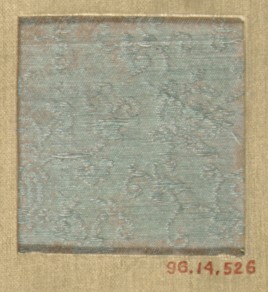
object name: piece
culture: japanese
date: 1701-1900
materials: silk